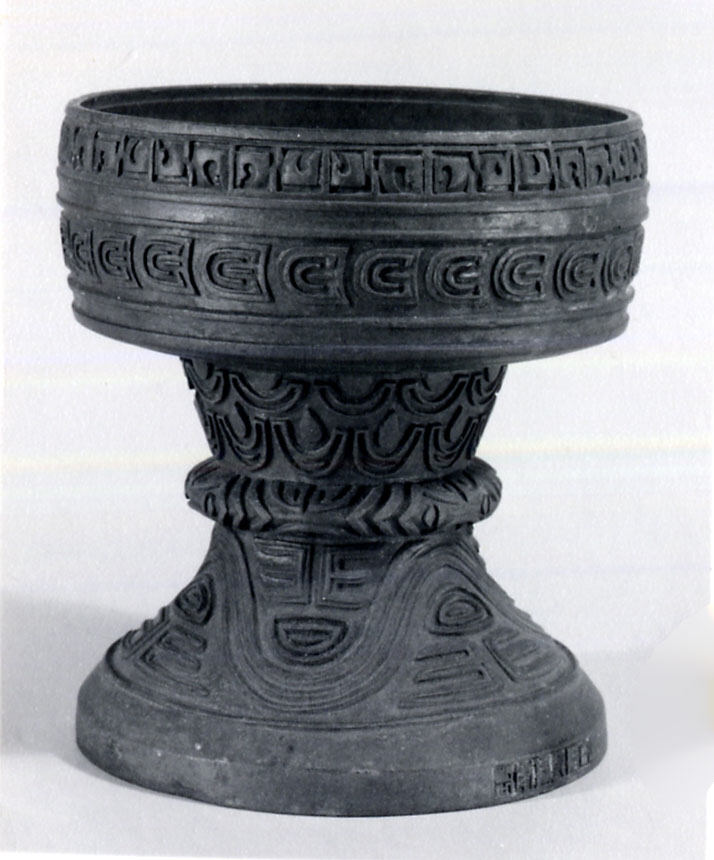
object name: vessel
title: Ceremonial Vessel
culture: chinese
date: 1736-1795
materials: bronze